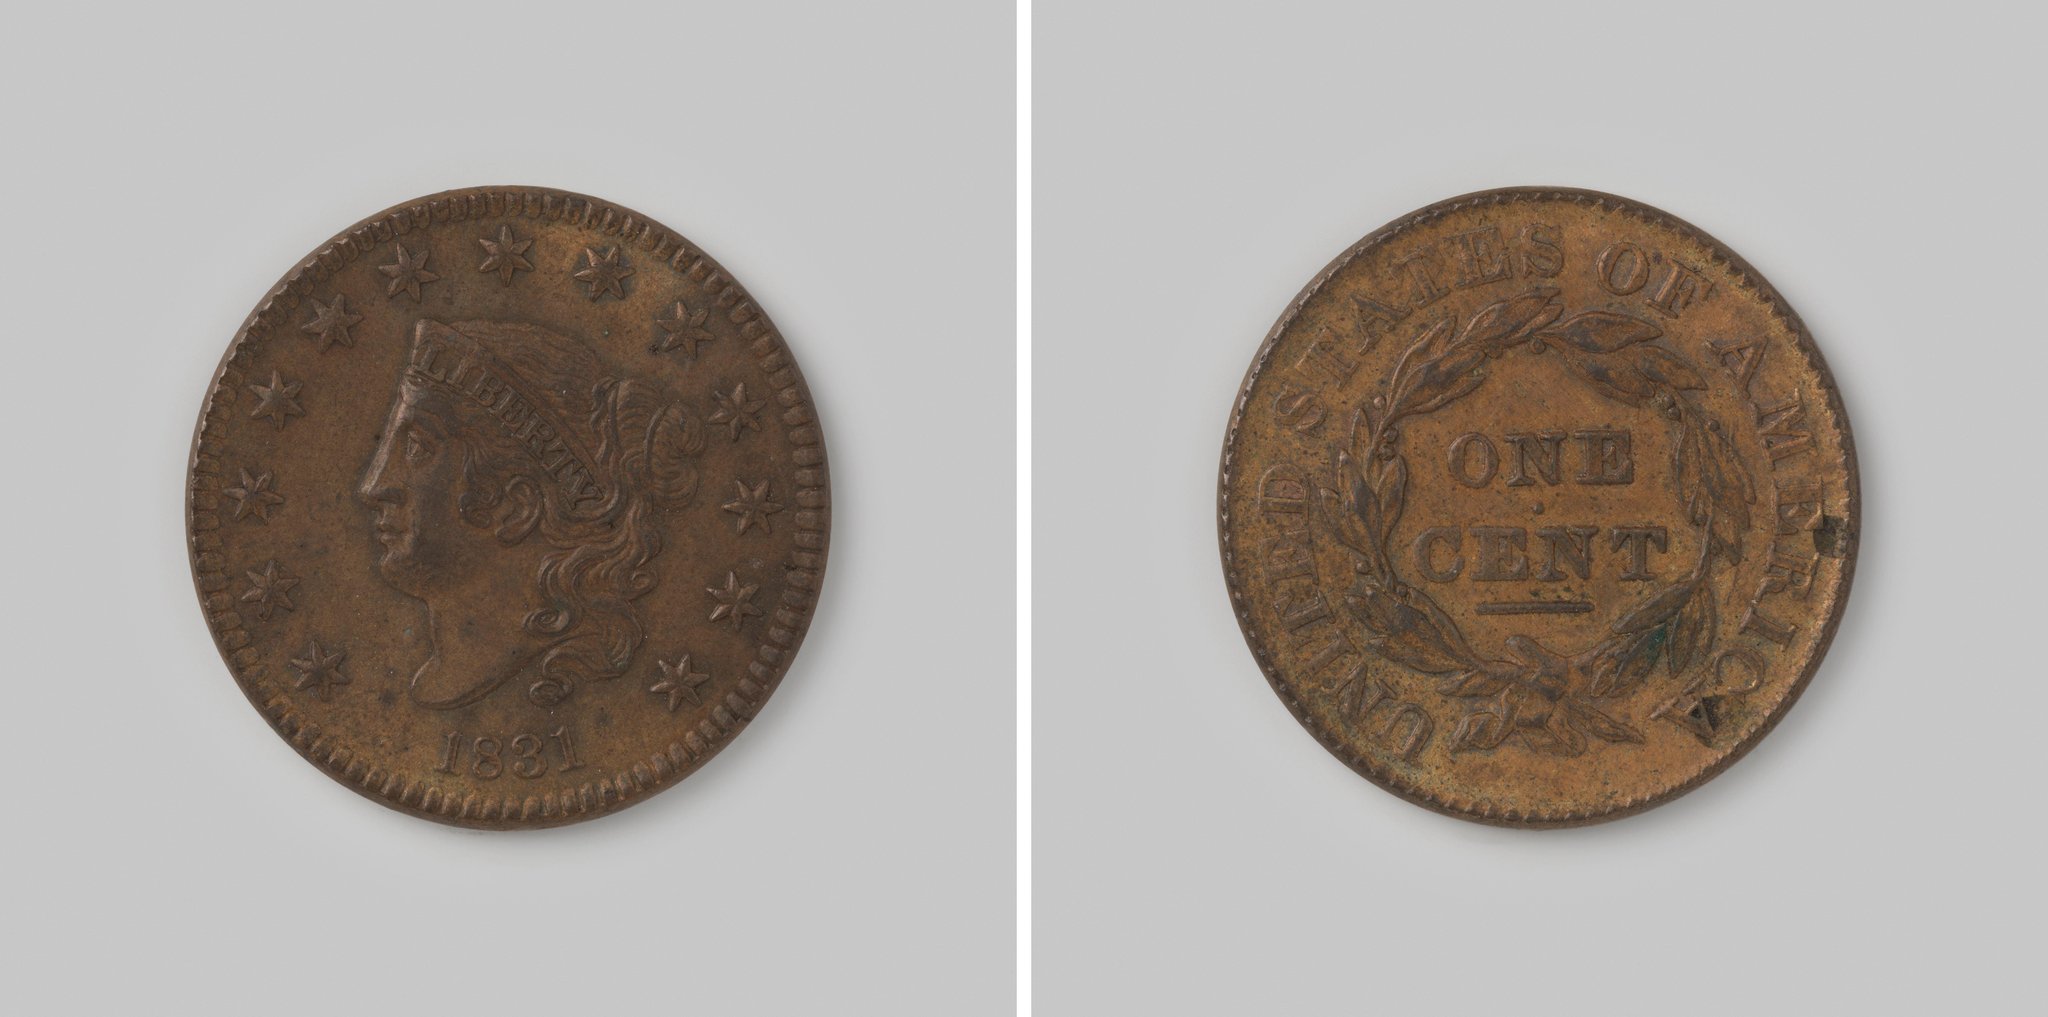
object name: coin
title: Verenigde Staten van Amerika, cent, 1831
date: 1831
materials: copper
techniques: striking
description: Koperen munt. Voorzijde: liberty naar links. Rondom haar een rij sterren. Onderaan jaartal. Keerzijde: tussen een in een cirkel geplooide, met een lint vastgebonden, tak waarde-aanduiding: one cent in twee regels. Gladde rand.